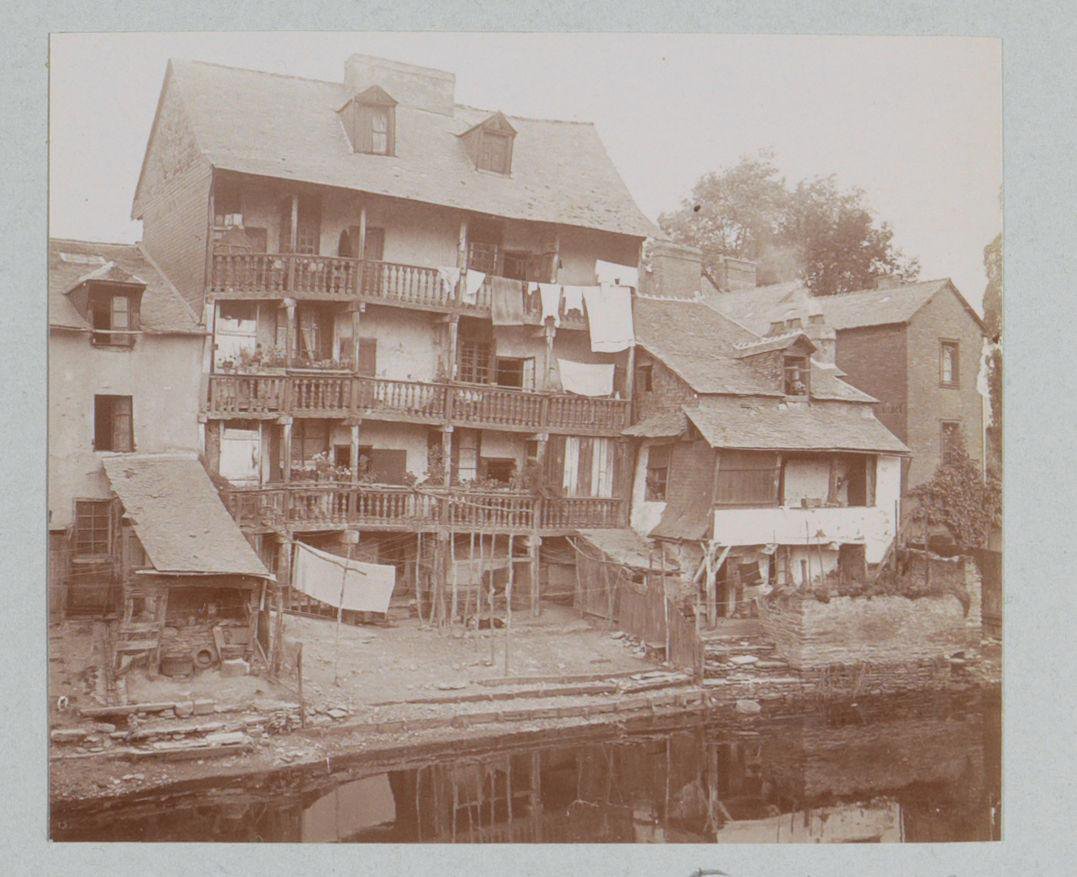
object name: photograph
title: Verwaarloosde achtergevels met balkons aan een water in Frankrijk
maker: Anonymous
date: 1905-1910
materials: paper, photographic support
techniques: gelatin silver print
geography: france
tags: balcony, façade (of house or building), france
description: Onderdeel van Fotoalbum van een Franse amateurfotograaf met bezienswaardigheden in Frankrijk, Zwitserland en Italië.